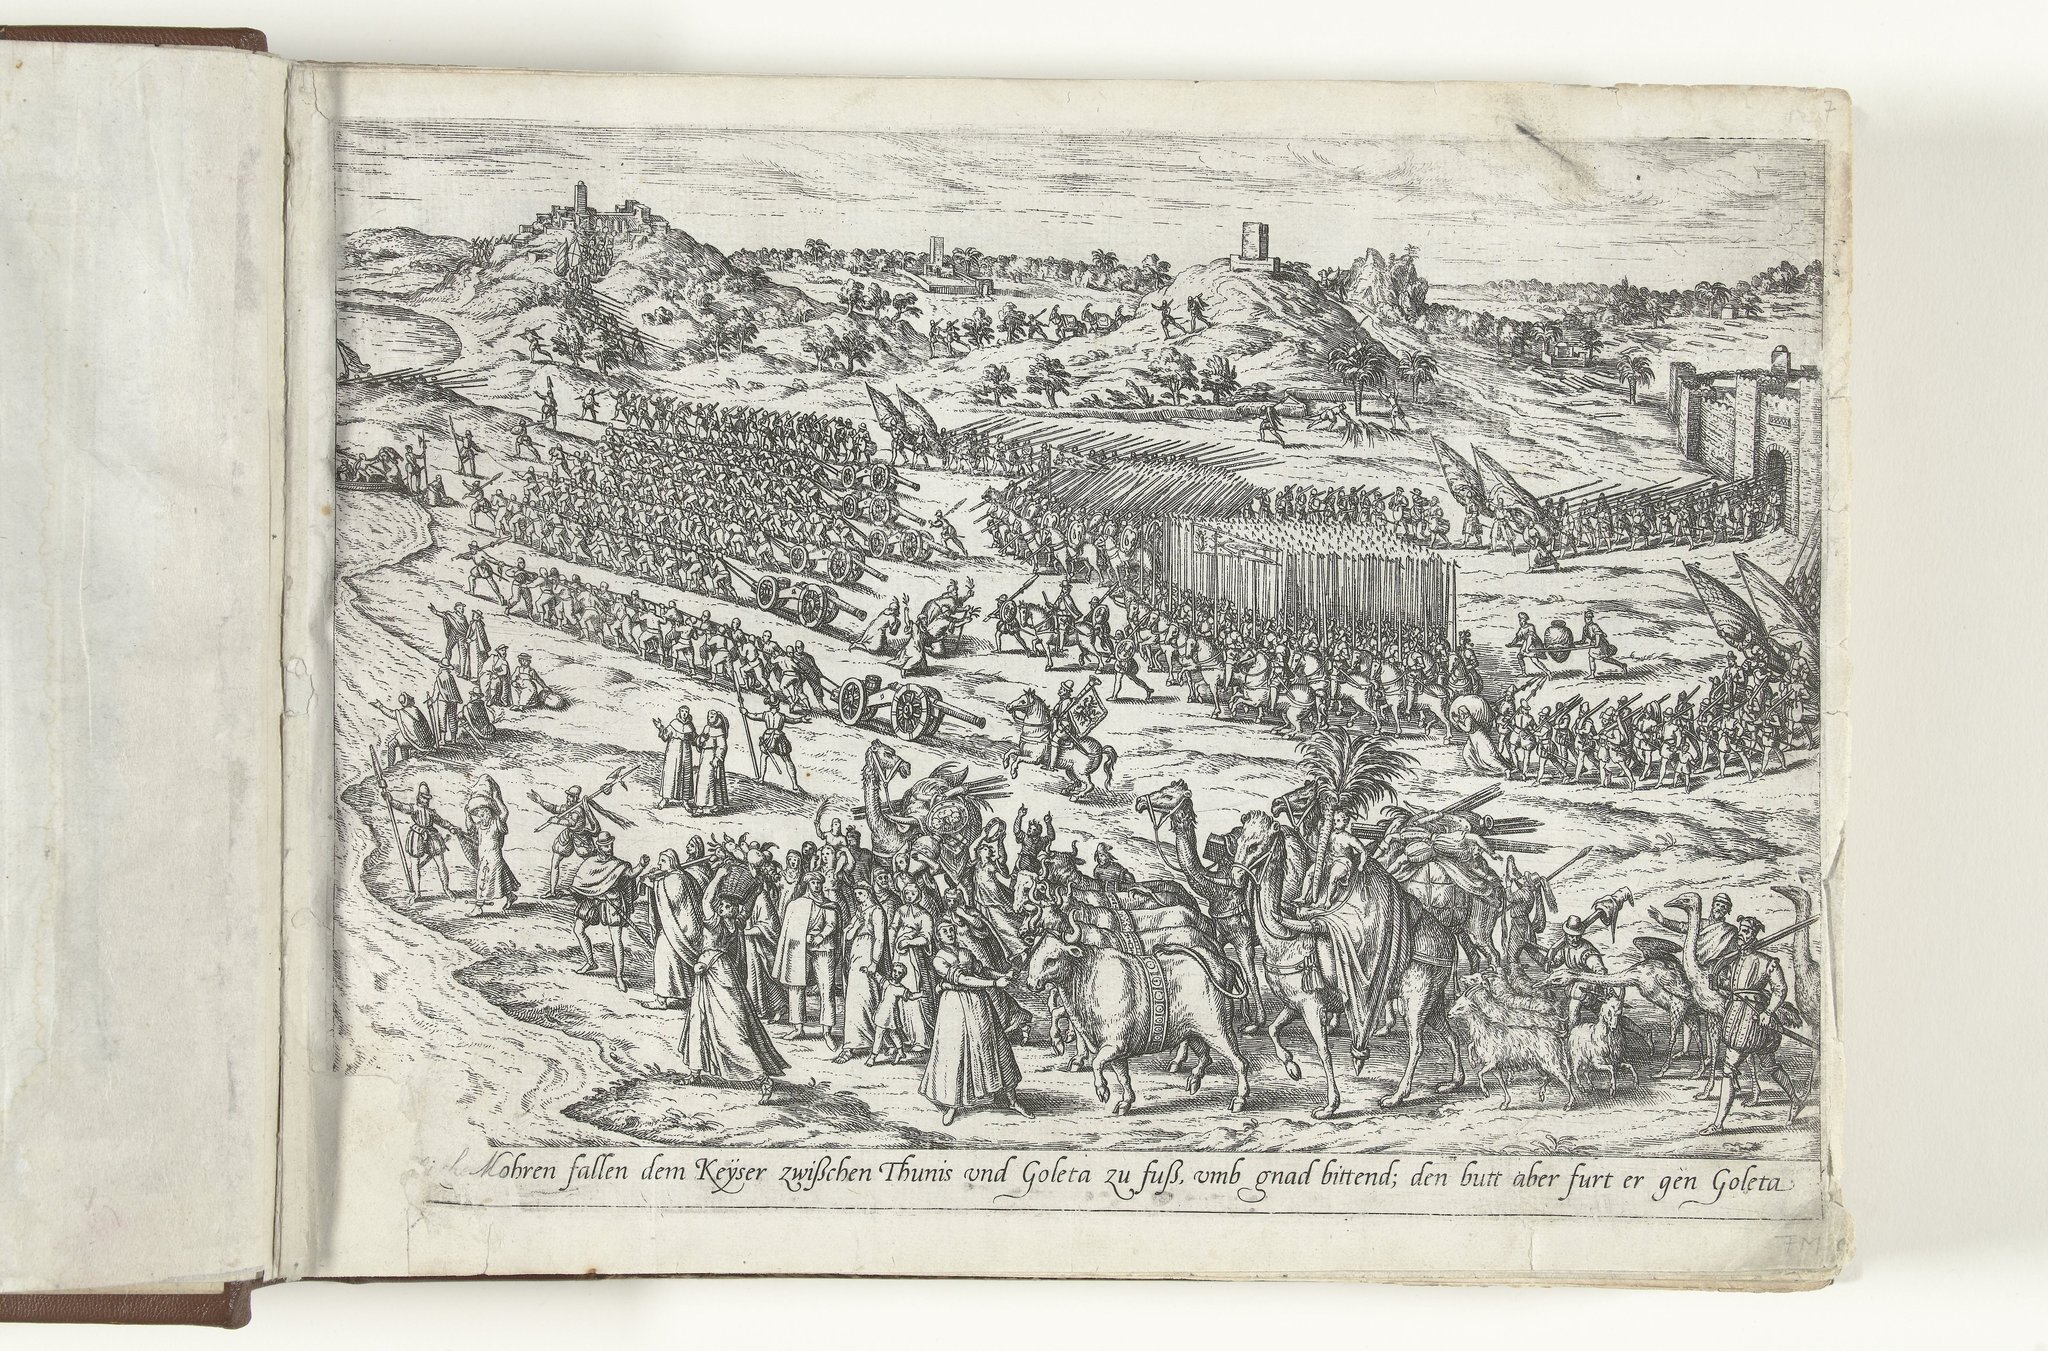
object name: album leaf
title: Serie 1: Tocht van Karel V naar Tunis, 1535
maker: frans hogenberg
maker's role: print maker, publisher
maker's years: 1538-1590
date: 1570-1574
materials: paper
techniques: etching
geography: cologne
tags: charles v (holy roman emperor and king of spain), communication and transport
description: Vier Turken knielen met takken in de hand voor Karel V en smeken hem om genade, 1535. Het keizerlijke leger trekt door het land tussen Tunis en Goleta, op de voorgrond een stoet van burgers met allerlei dieren. Hoek linksonder met nummer [7] ontbreekt.